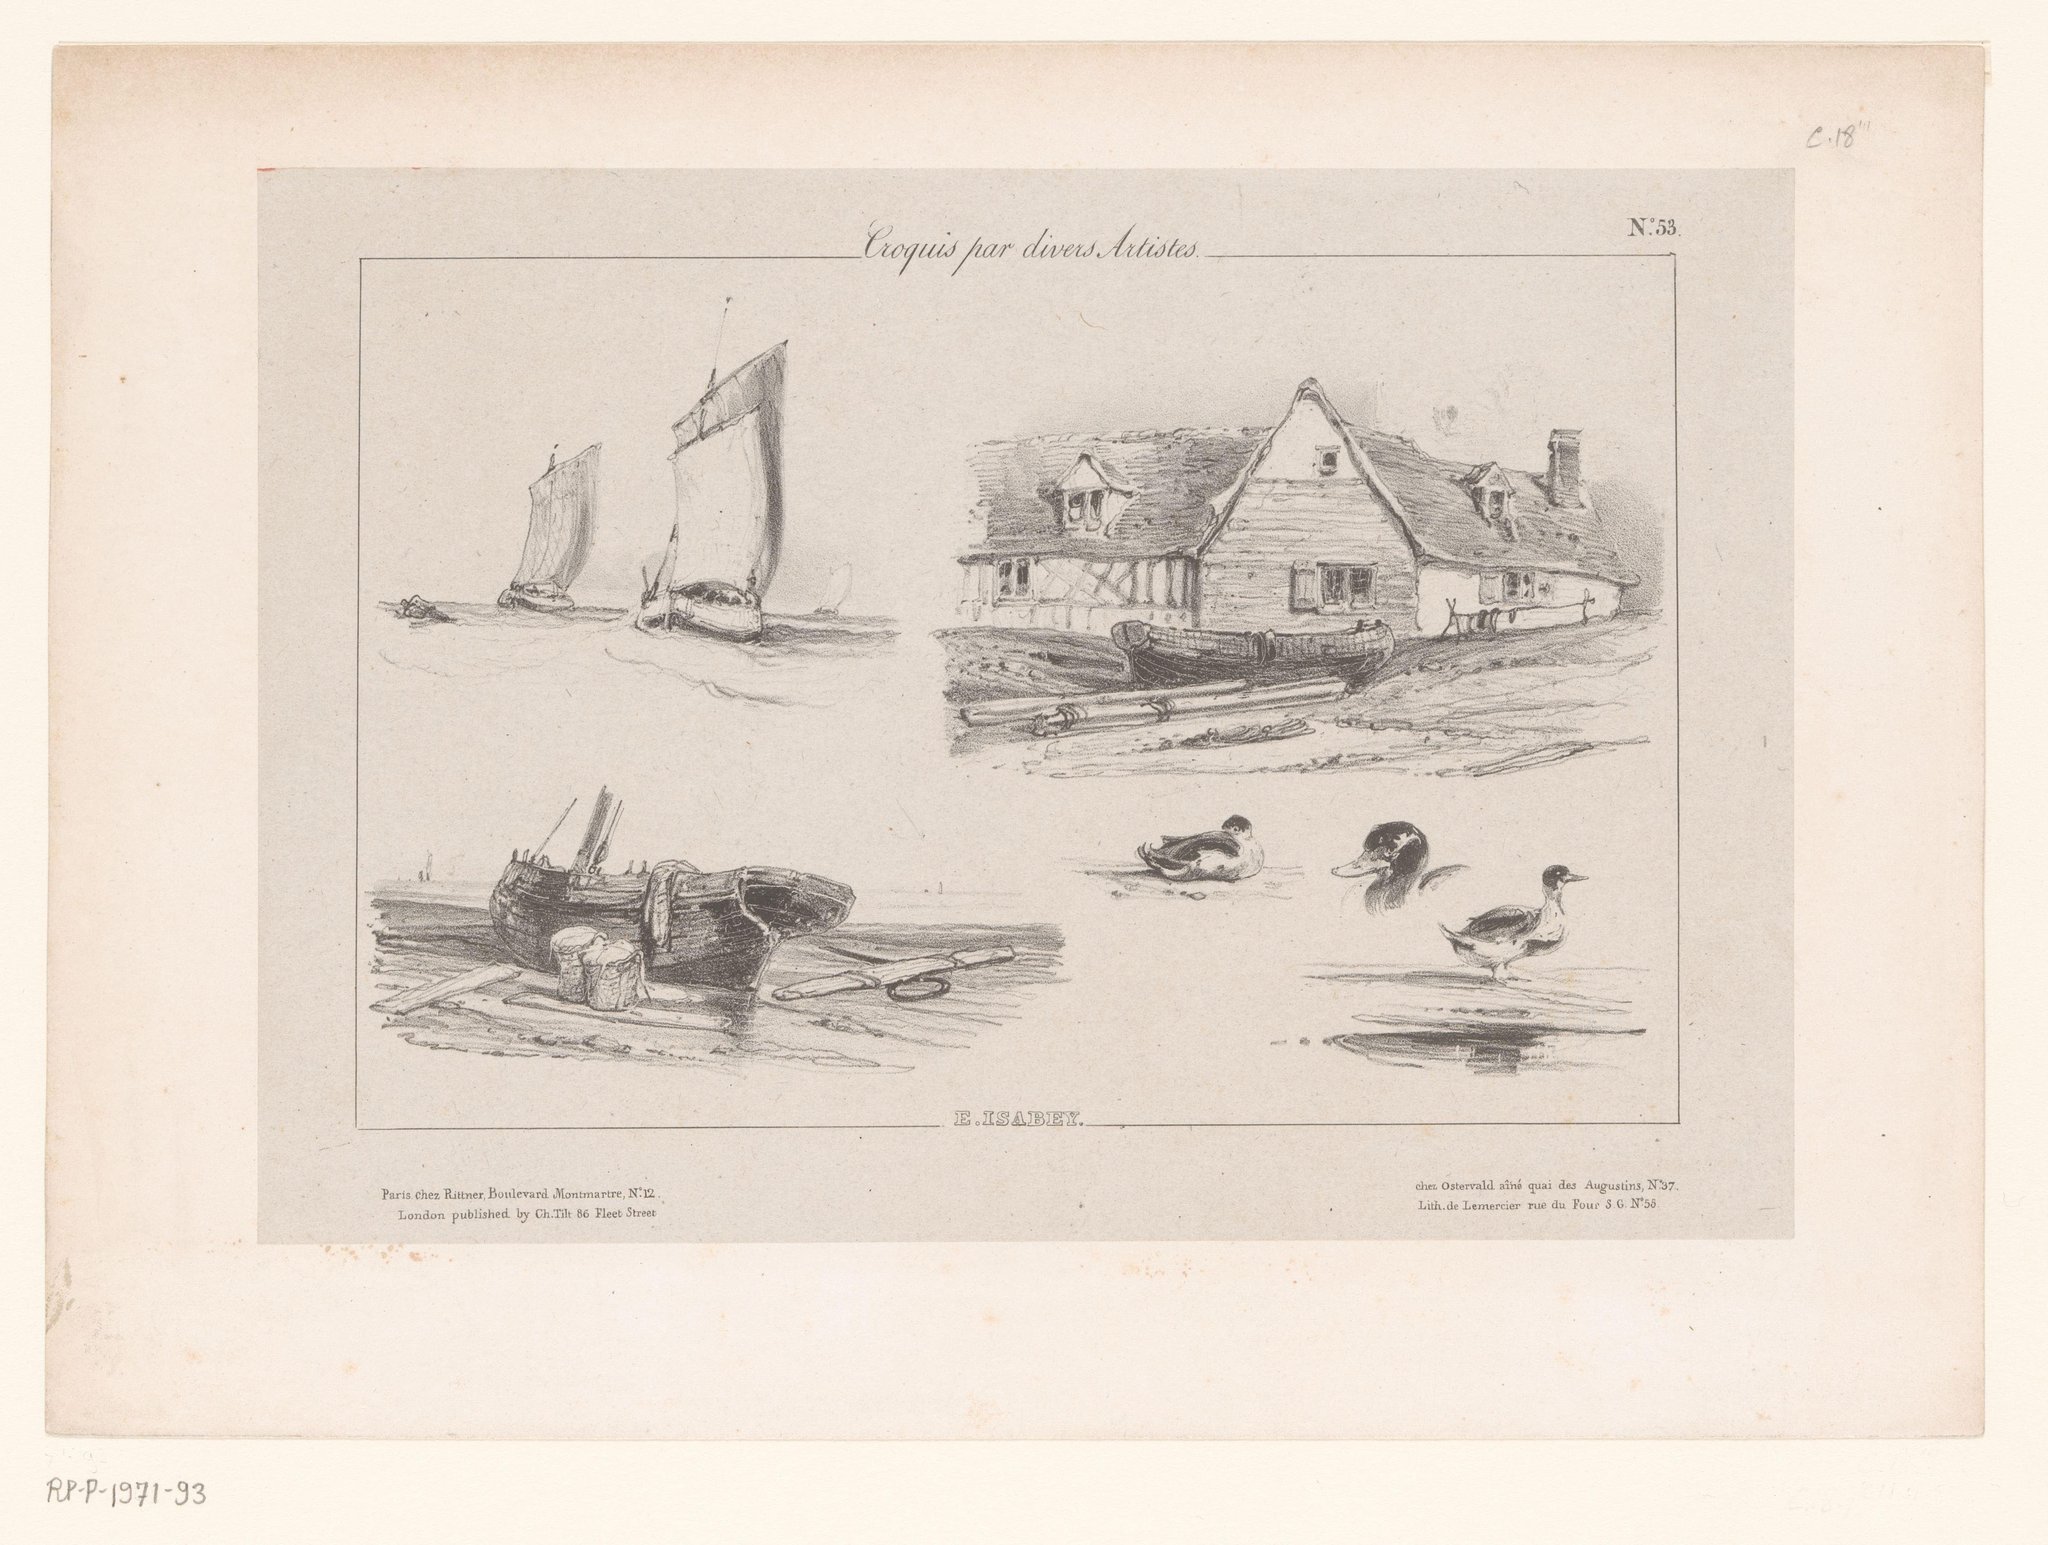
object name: print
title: Schetsen van vissersboten, eenden en een huis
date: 1830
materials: paper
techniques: lithograph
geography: london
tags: parts (of house or building), sailing-ship, sailing-boat, coast, water-birds: duck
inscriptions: collector's mark: Lugt 2228a, collector's mark: Lugt 2760